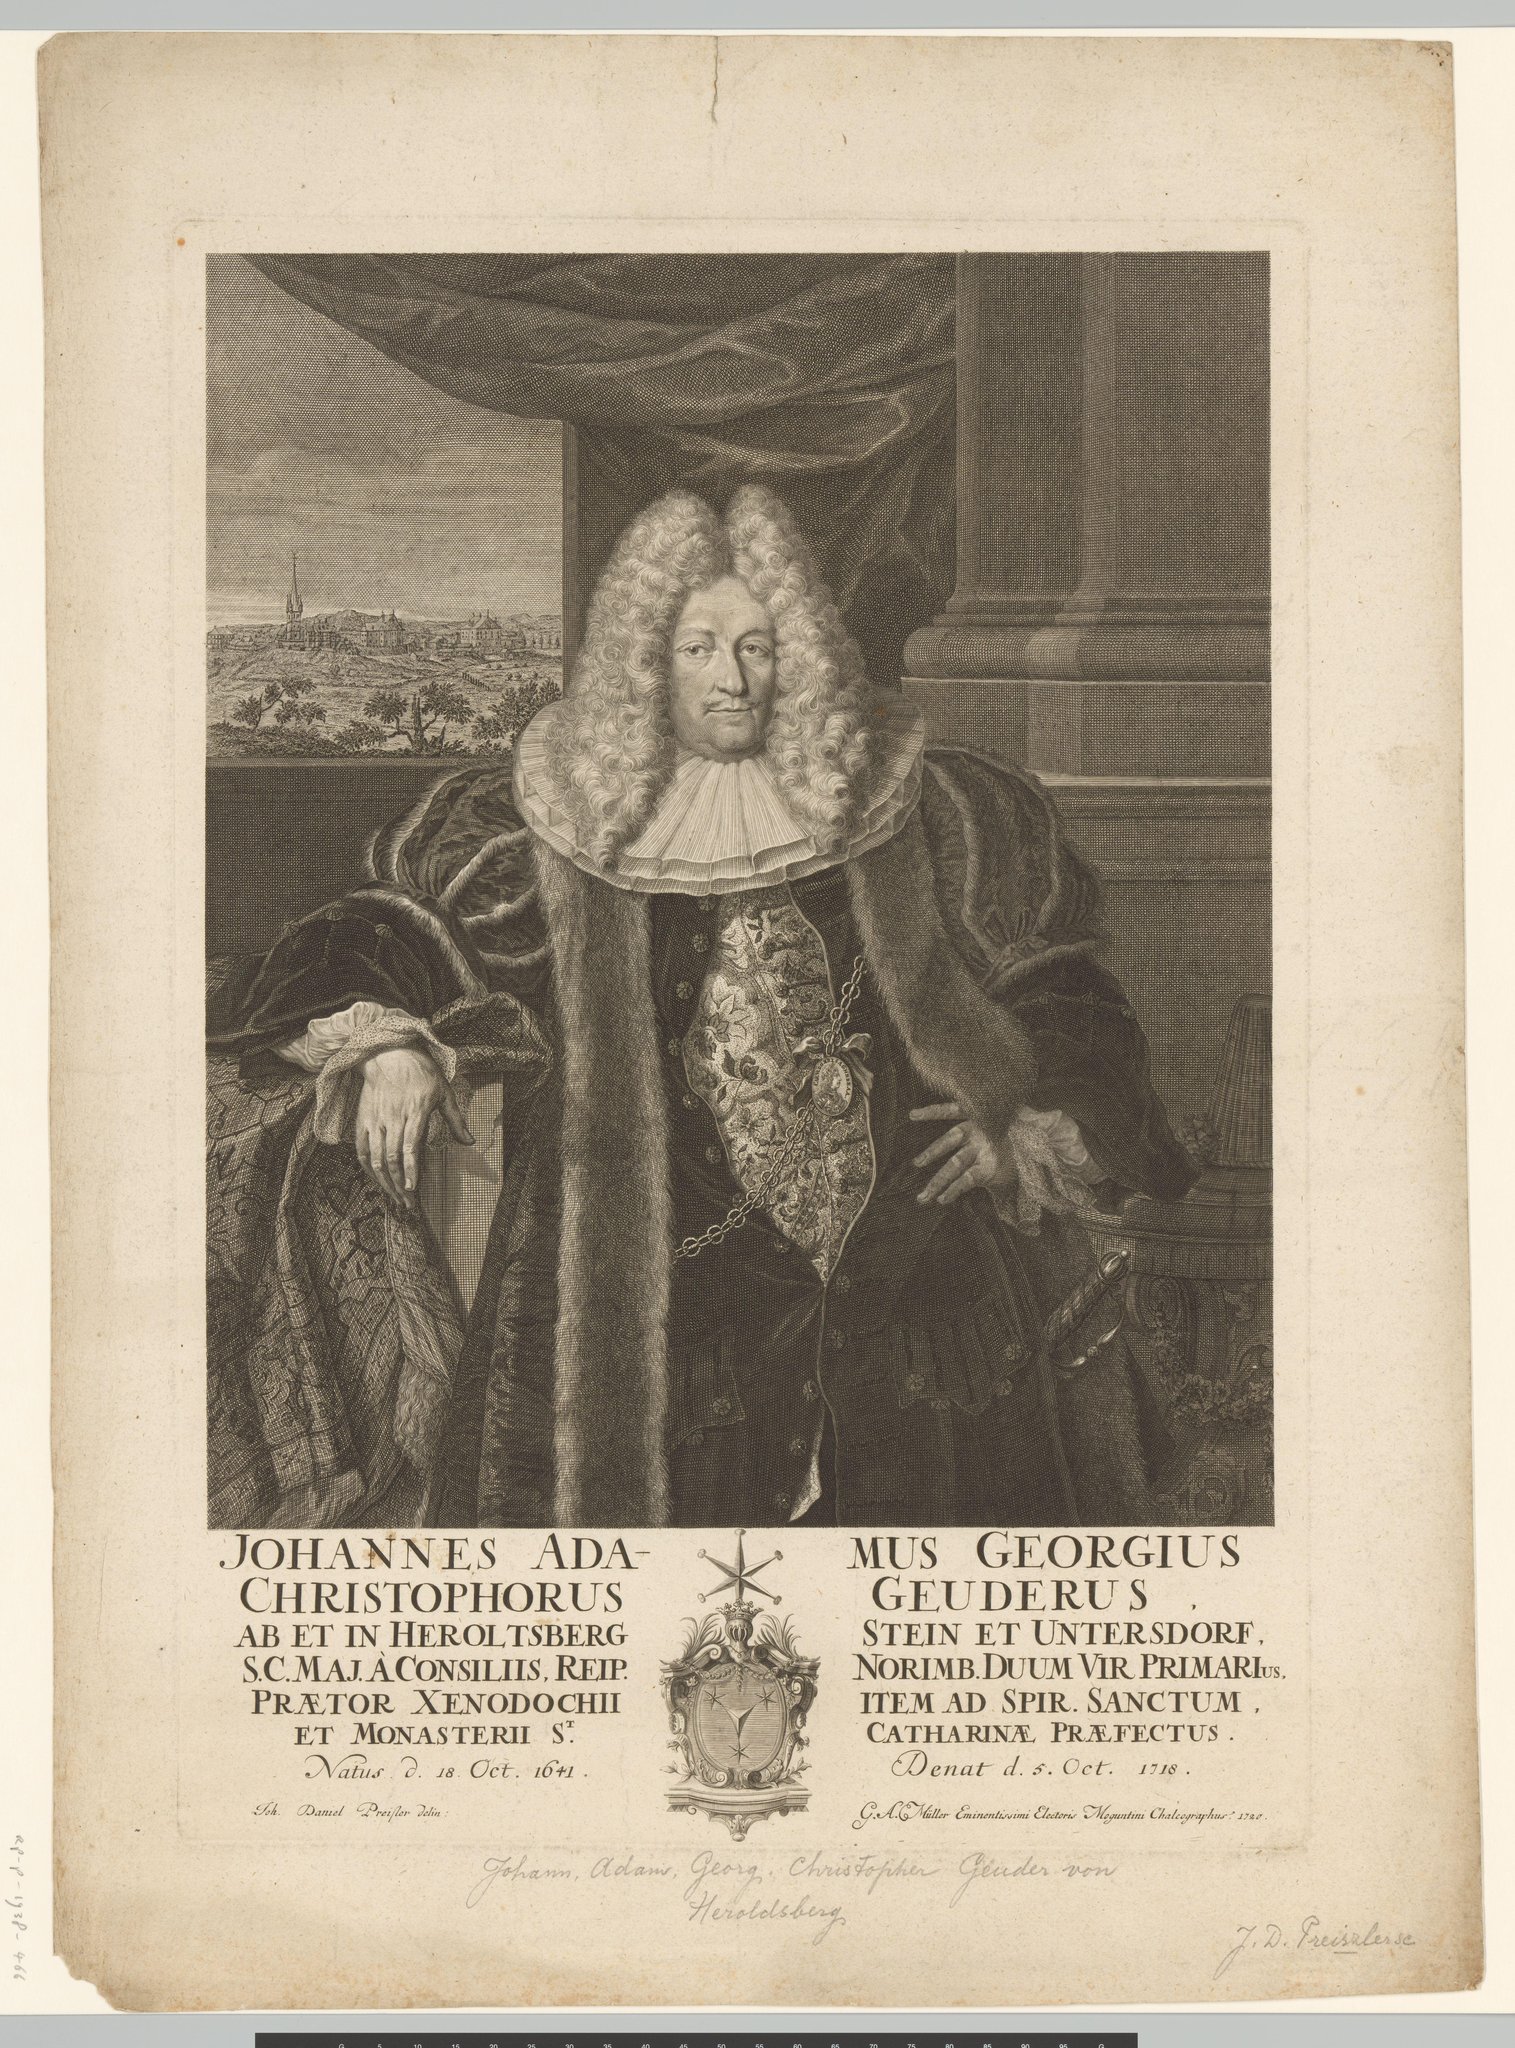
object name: print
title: Portret van Johann Adam Georg Christoph Geuder von Heroldsberg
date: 1720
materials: paper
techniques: engraving, etching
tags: mayor, city-view in general; 'veduta', other non-personal regalia, e.g. mayor chain, historical persons, hacking and thrusting weapons: sword, pendant, trinket, 'breloque', armorial bearing, heraldry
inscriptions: collector's mark: Lugt 2228, name, name